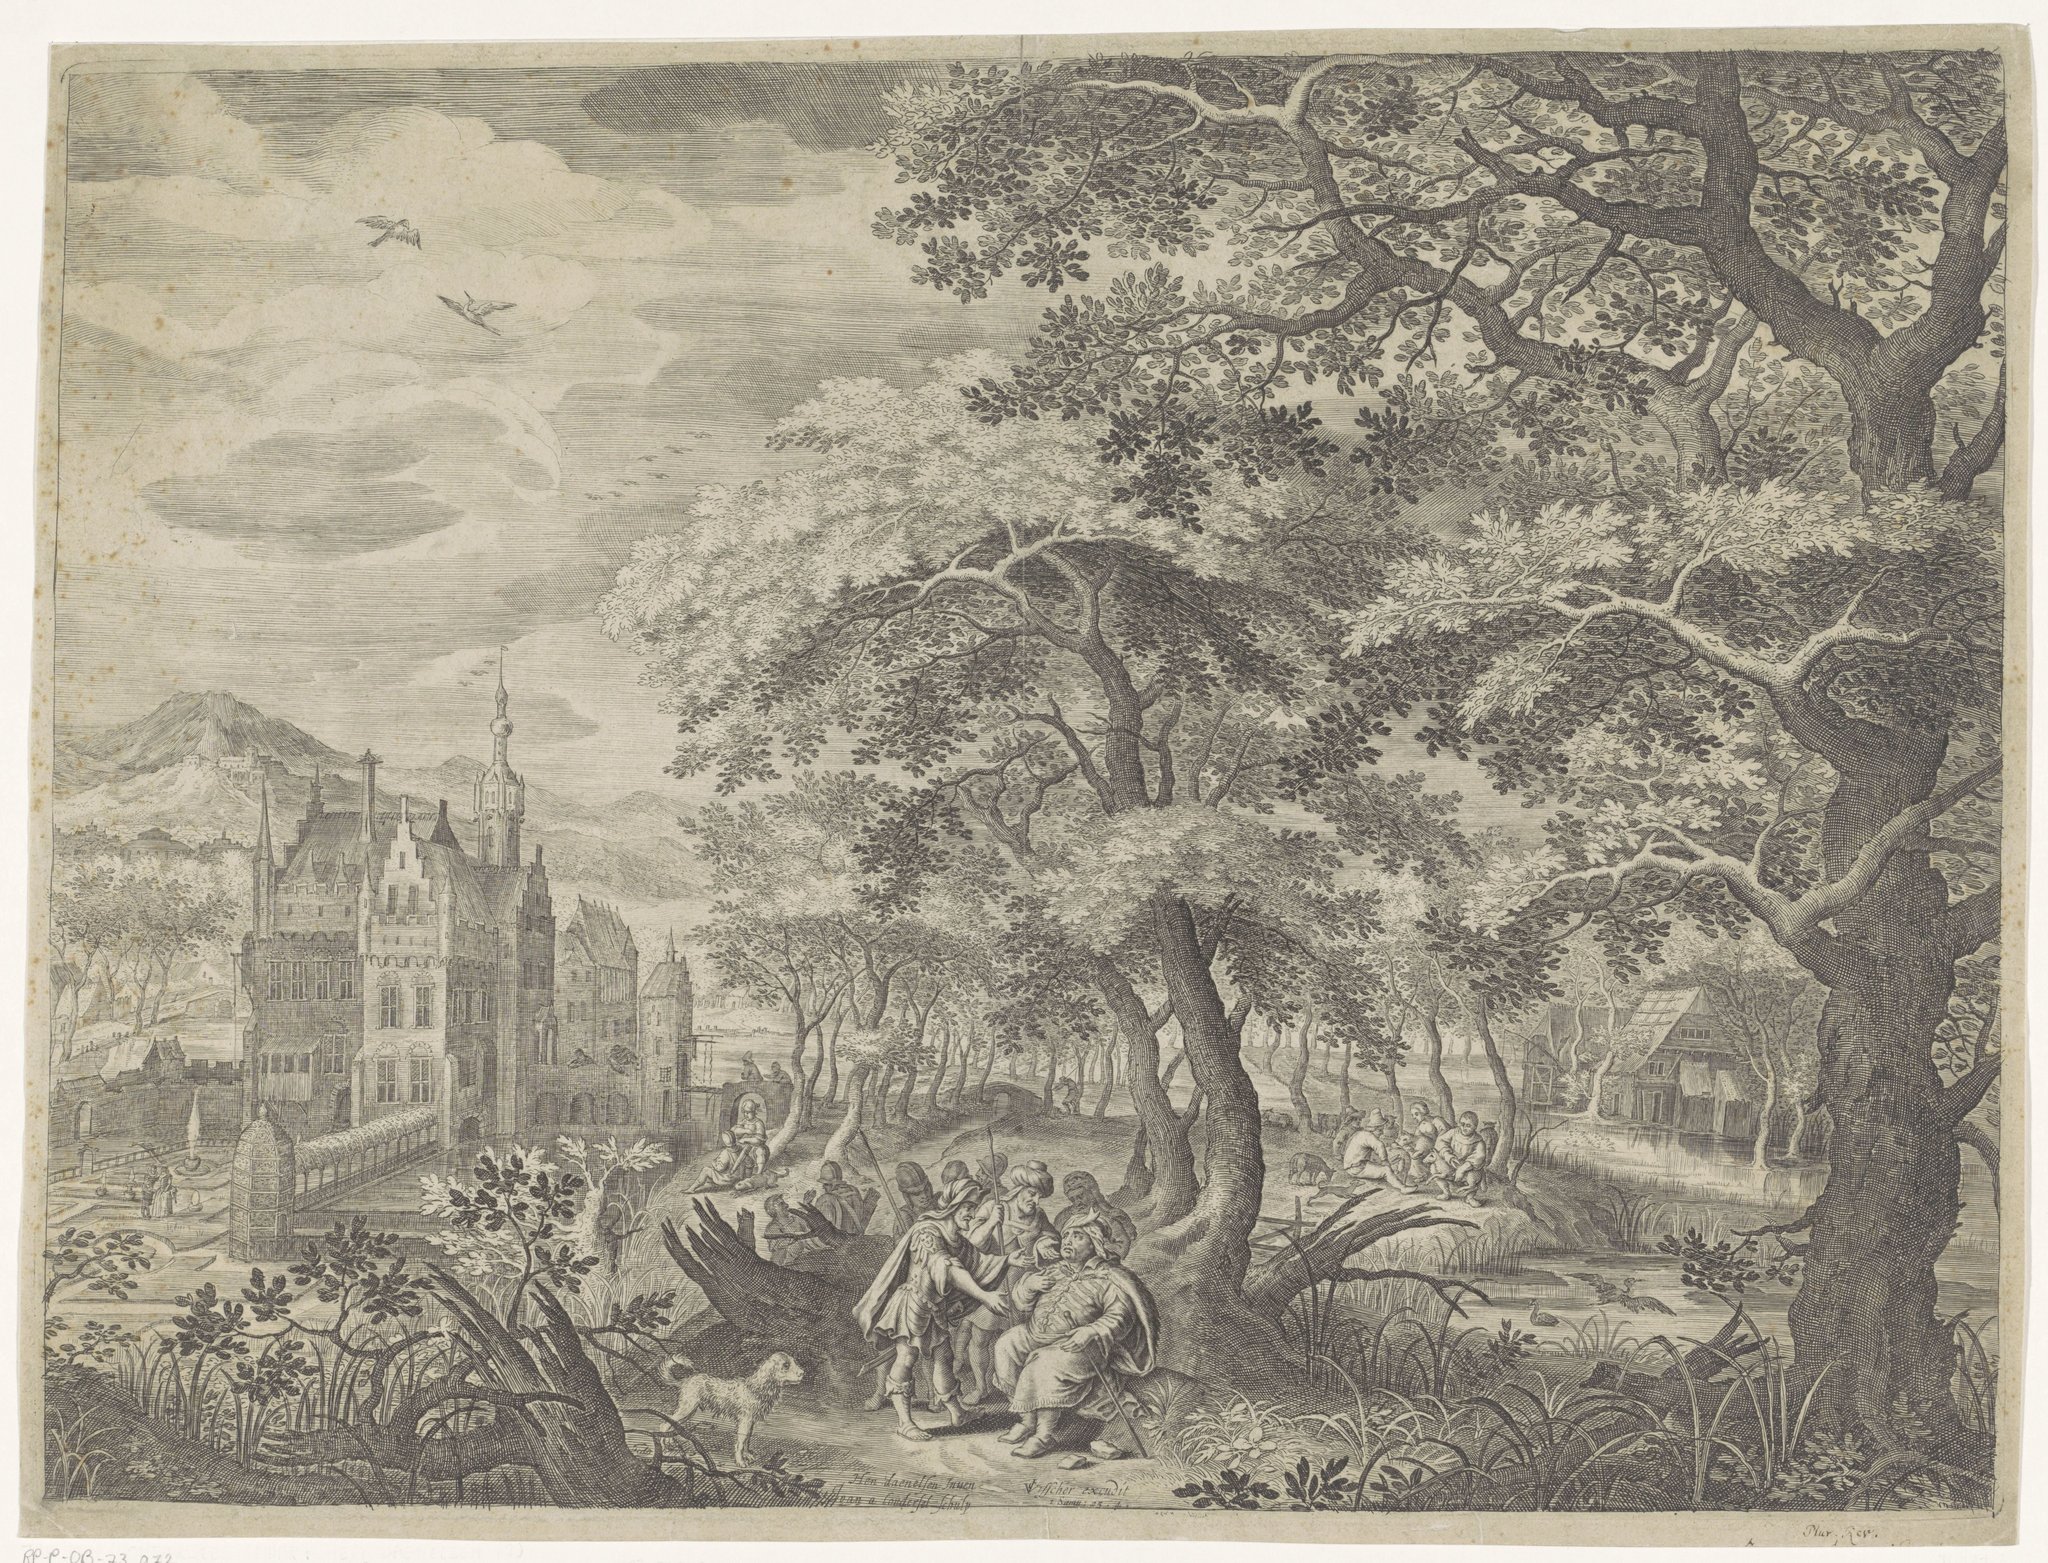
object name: print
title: Landschap met Davids mannen die Nabal om voedsel vragen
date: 1585-1625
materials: paper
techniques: engraving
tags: landscape with tower or castle, ten servants sent by david come to nabal to ask for food; nabal and his men may be shown shearing sheep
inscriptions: collector's mark: Lugt 2656, collector's mark: Lugt 2228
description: De Amsterdamse uitgever Claes Jansz. Visscher (II) produceerde vanaf de jaren ’30 van de zeventiende eeuw grote Bijbelse prenten op zogenaamd royaal-formaat papier (ca. 480 x 580 mm). Na zijn dood in 1652 zette zijn zoon Nicolaes Visscher (I) het bedrijf voort en zo ook de uitgave van Royaalbijbelprenten. Toen Nicolaes in 1679 overleed nam zijn zoon Nicolaes Visscher (II) het bedrijf over en gaf kort hierna, omstreeks 1680, een fondslijst uit. Hierin worden 130 prenten met Bijbelse voorstellingen op royaalpapier beschreven (zie documentatie J. van der Waals). Complete prentbijbels op royaal-formaat werden door vader en zoon Nicolaes Visscher uitgegeven onder de titel Historiae Sacrae Veteris et Novi Testamenti. De bladen werden echter ook los verkocht en konden worden gecombineerd met Royaalbijbel-prenten van andere uitgevers. Verschillende Amsterdamse uitgevers brachten namelijk ook bijbelprenten op royaal-formaat uit, onder wie Clement de Jonghe en Cornelis Danckerts. De door de firma Visscher uitgegeven prenten zijn veelal vervaardigd door anonieme prentmakers naar voorbeeld van verschillende zestiende- en zeventiende-eeuwse Bijbelse prenten en prentreeksen. Veelal moesten de composities worden aangepast aan het grotere en langgerekte royaal-formaat. Daarnaast zijn er ook grote bladen van bekende prentmakers zoals Jan van Londerseel, Pieter Nolpe, Jacques de Gheyn (II) en Jan Harmensz. Muller opgenomen in de categorie ‘Bybelsche Figuren, op Royaal-bladen’ in de fondslijst van Visscher. Prent mogelijk gebruikt in: Historiae Sacrae Veteris et Novi Testamenti (Royaalbijbel). Amsterdam: Nicolaes Visscher (I) en (II), [1652-1702]. In de fondslijst van Nicolaes Visscher II (ca. 1680) is het onderwerp van deze prent onder de titel 'Bybelsche Figuren, op Royaal-bladen. bestaande uyt de volgende historien.' als volgt genummerd: 39.